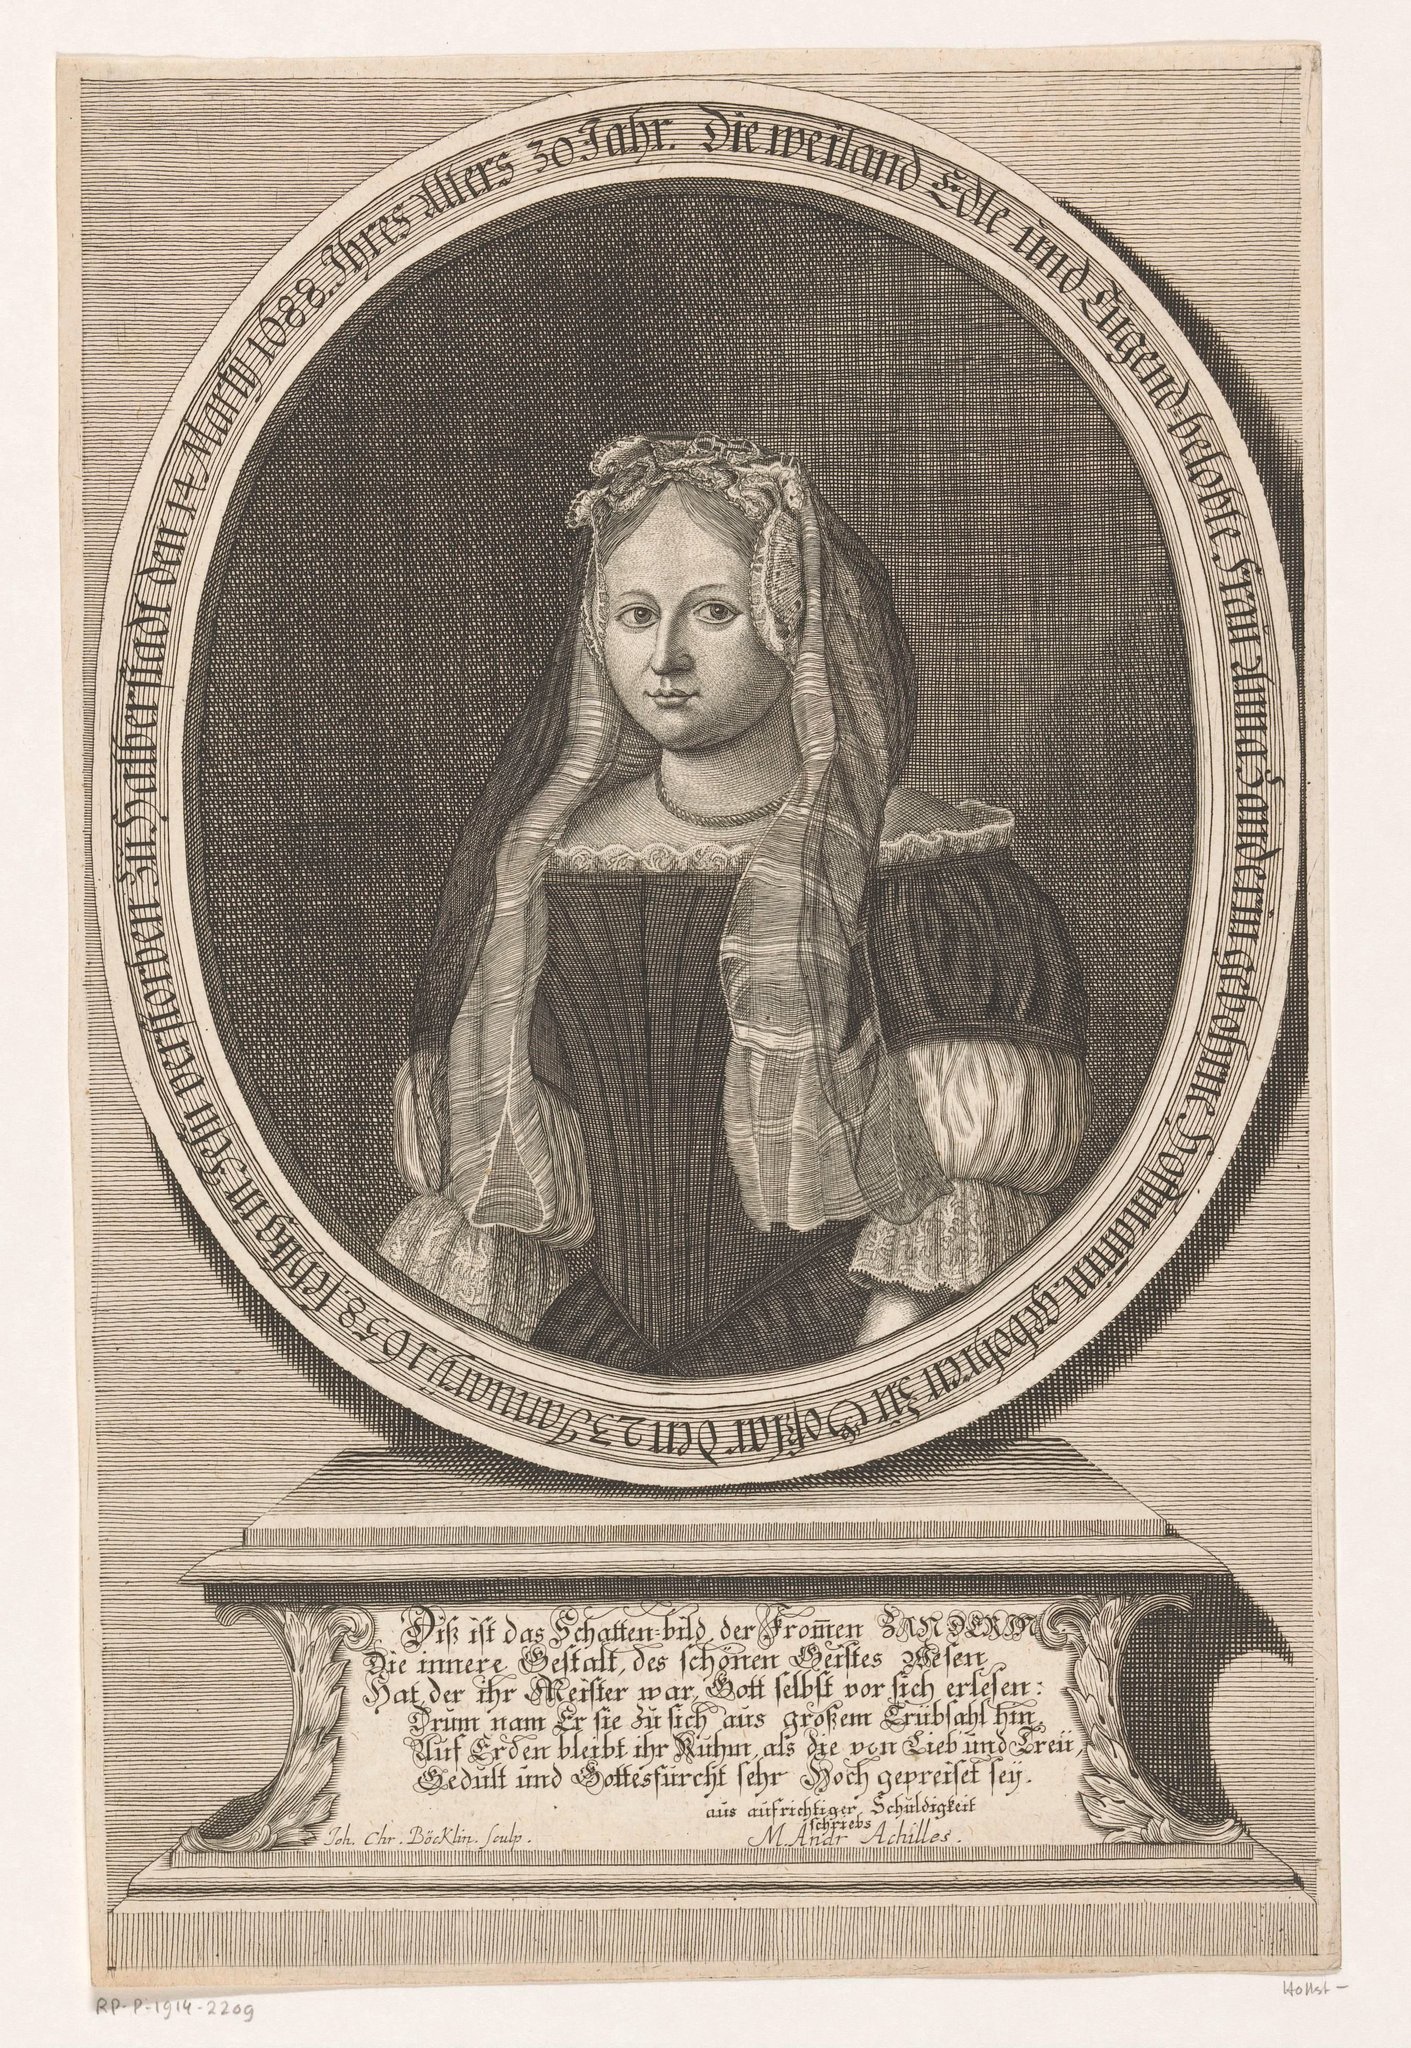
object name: print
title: Portret van Anna Zander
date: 1688-1709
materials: paper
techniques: engraving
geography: leipzig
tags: historical persons - bb - woman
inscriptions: collector's mark: Lugt 2228